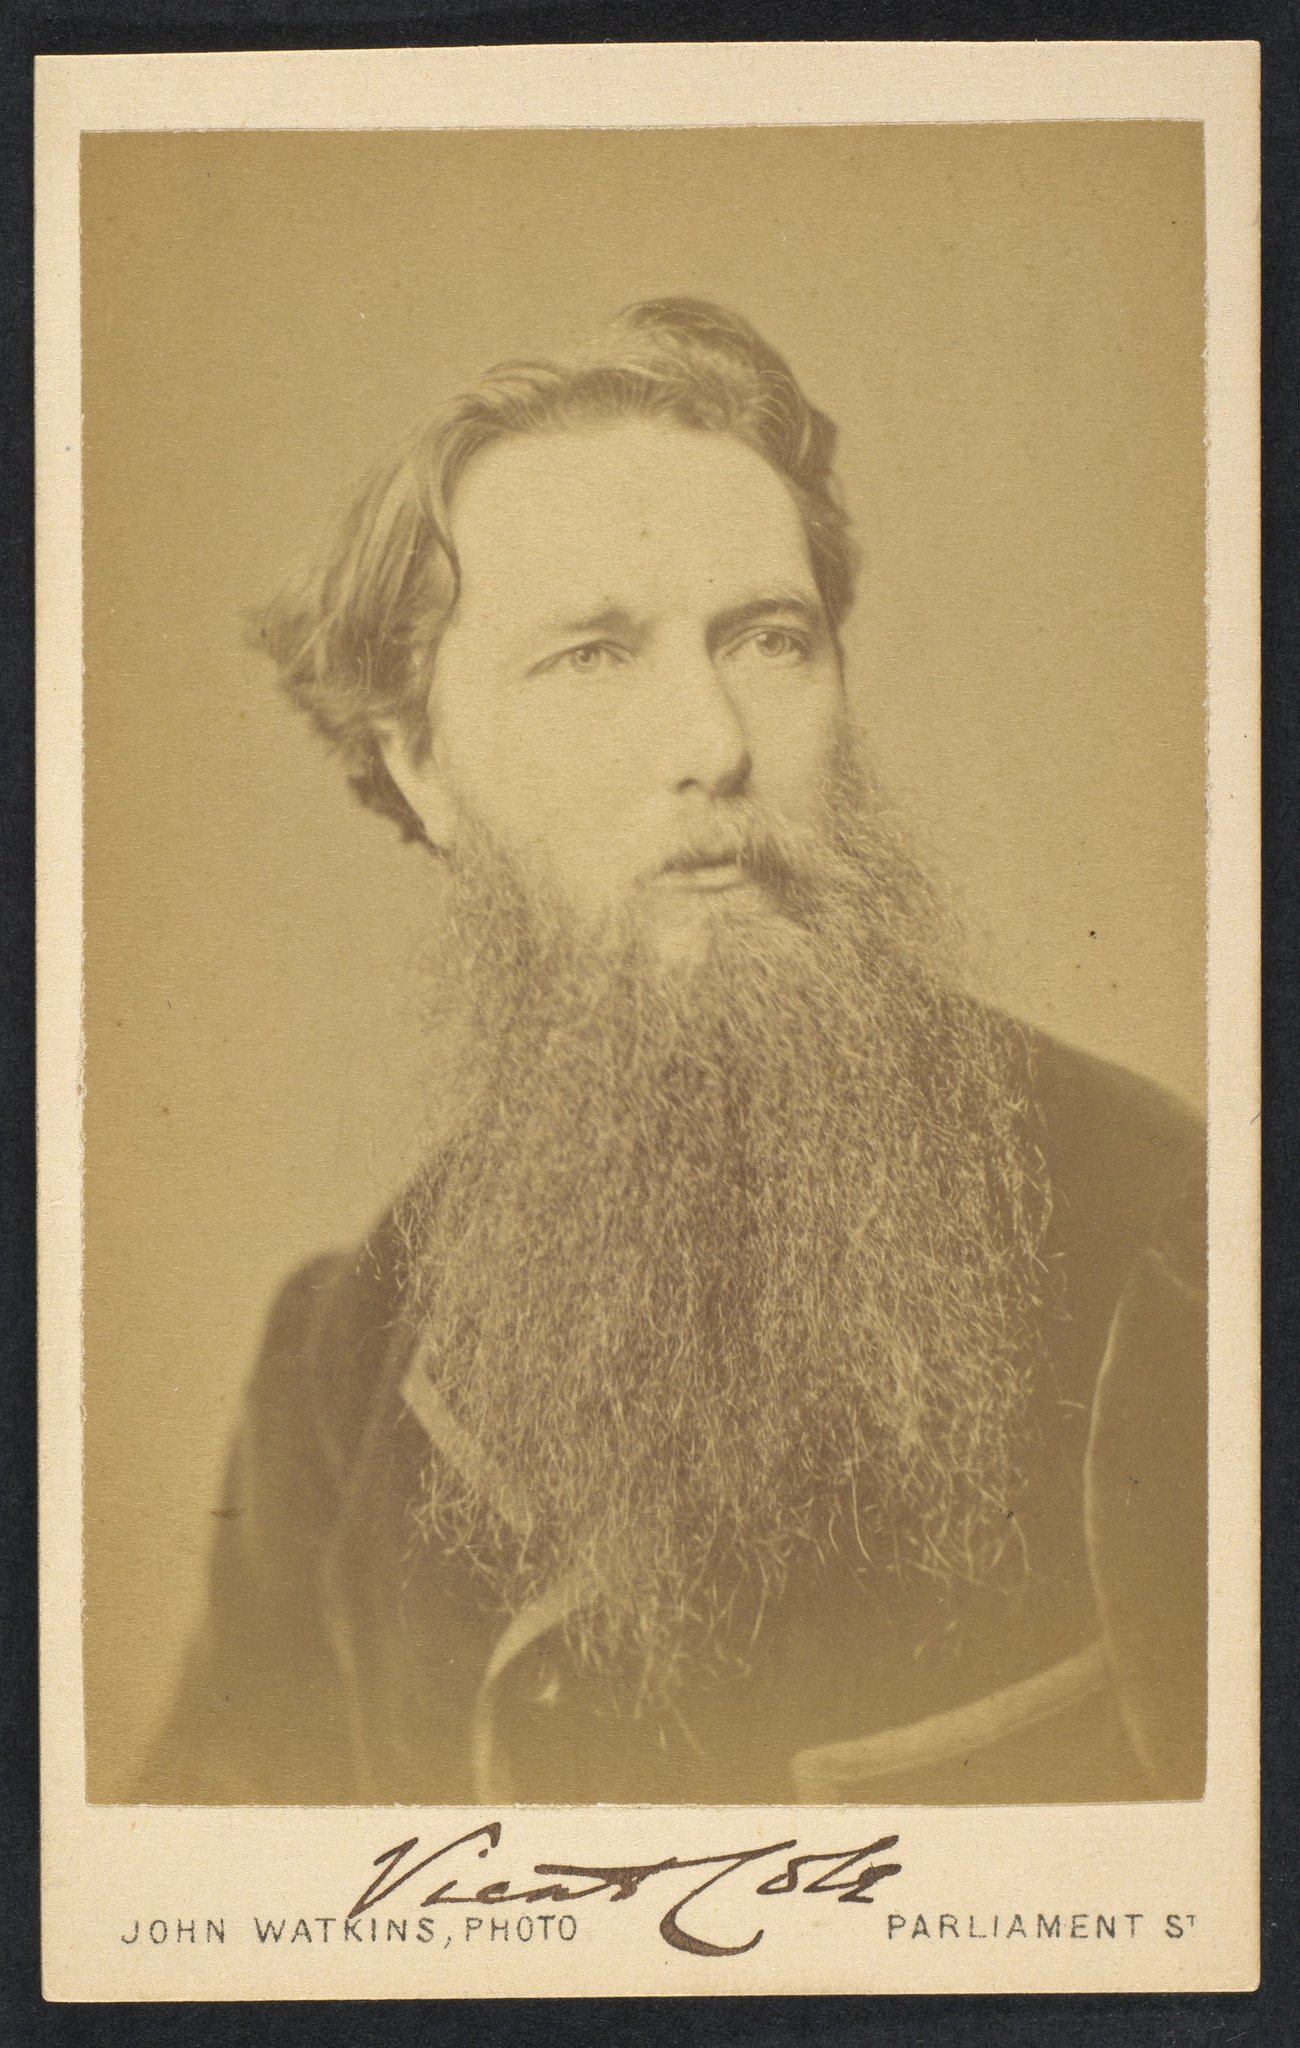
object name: carte de visite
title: [George Vicat Cole]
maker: john and charles watkins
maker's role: photography studio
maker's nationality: british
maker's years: 1840-1875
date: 1860-1869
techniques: albumen silver print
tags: men,portraits